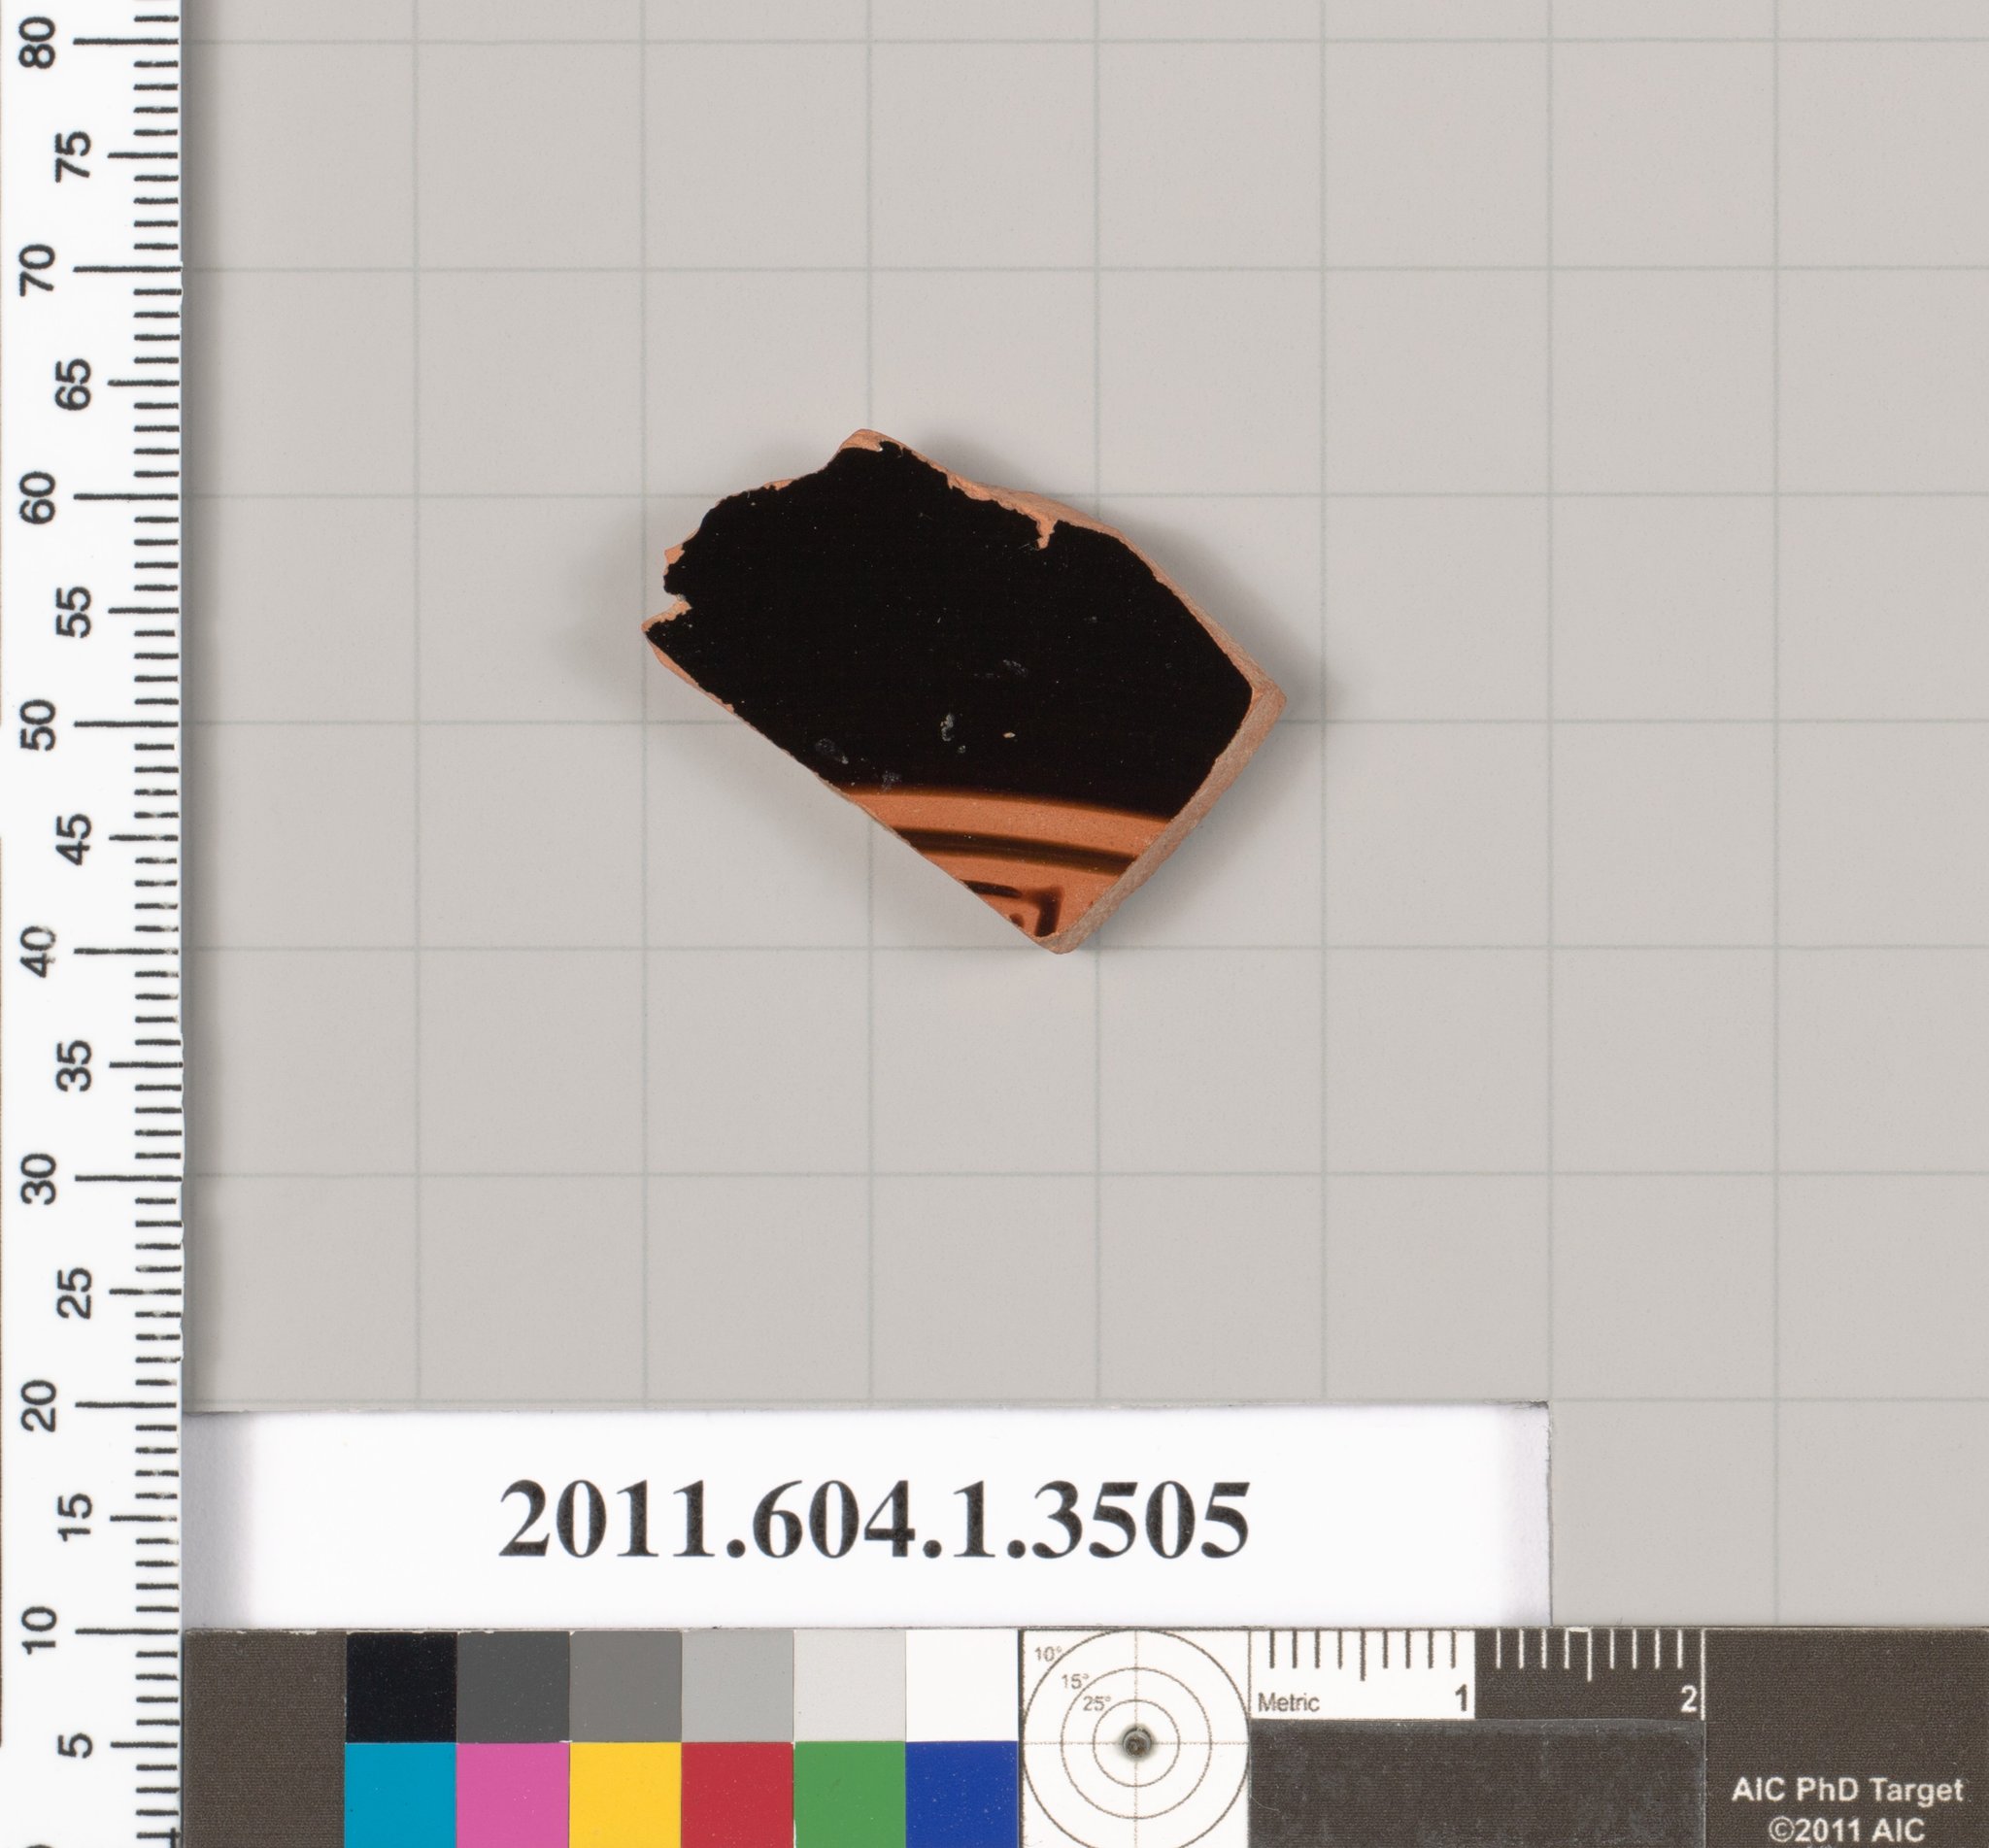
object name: kylix fragment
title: Terracotta fragment of a kylix (drinking cup)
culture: greek, attic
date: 490-480 BCE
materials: terracotta